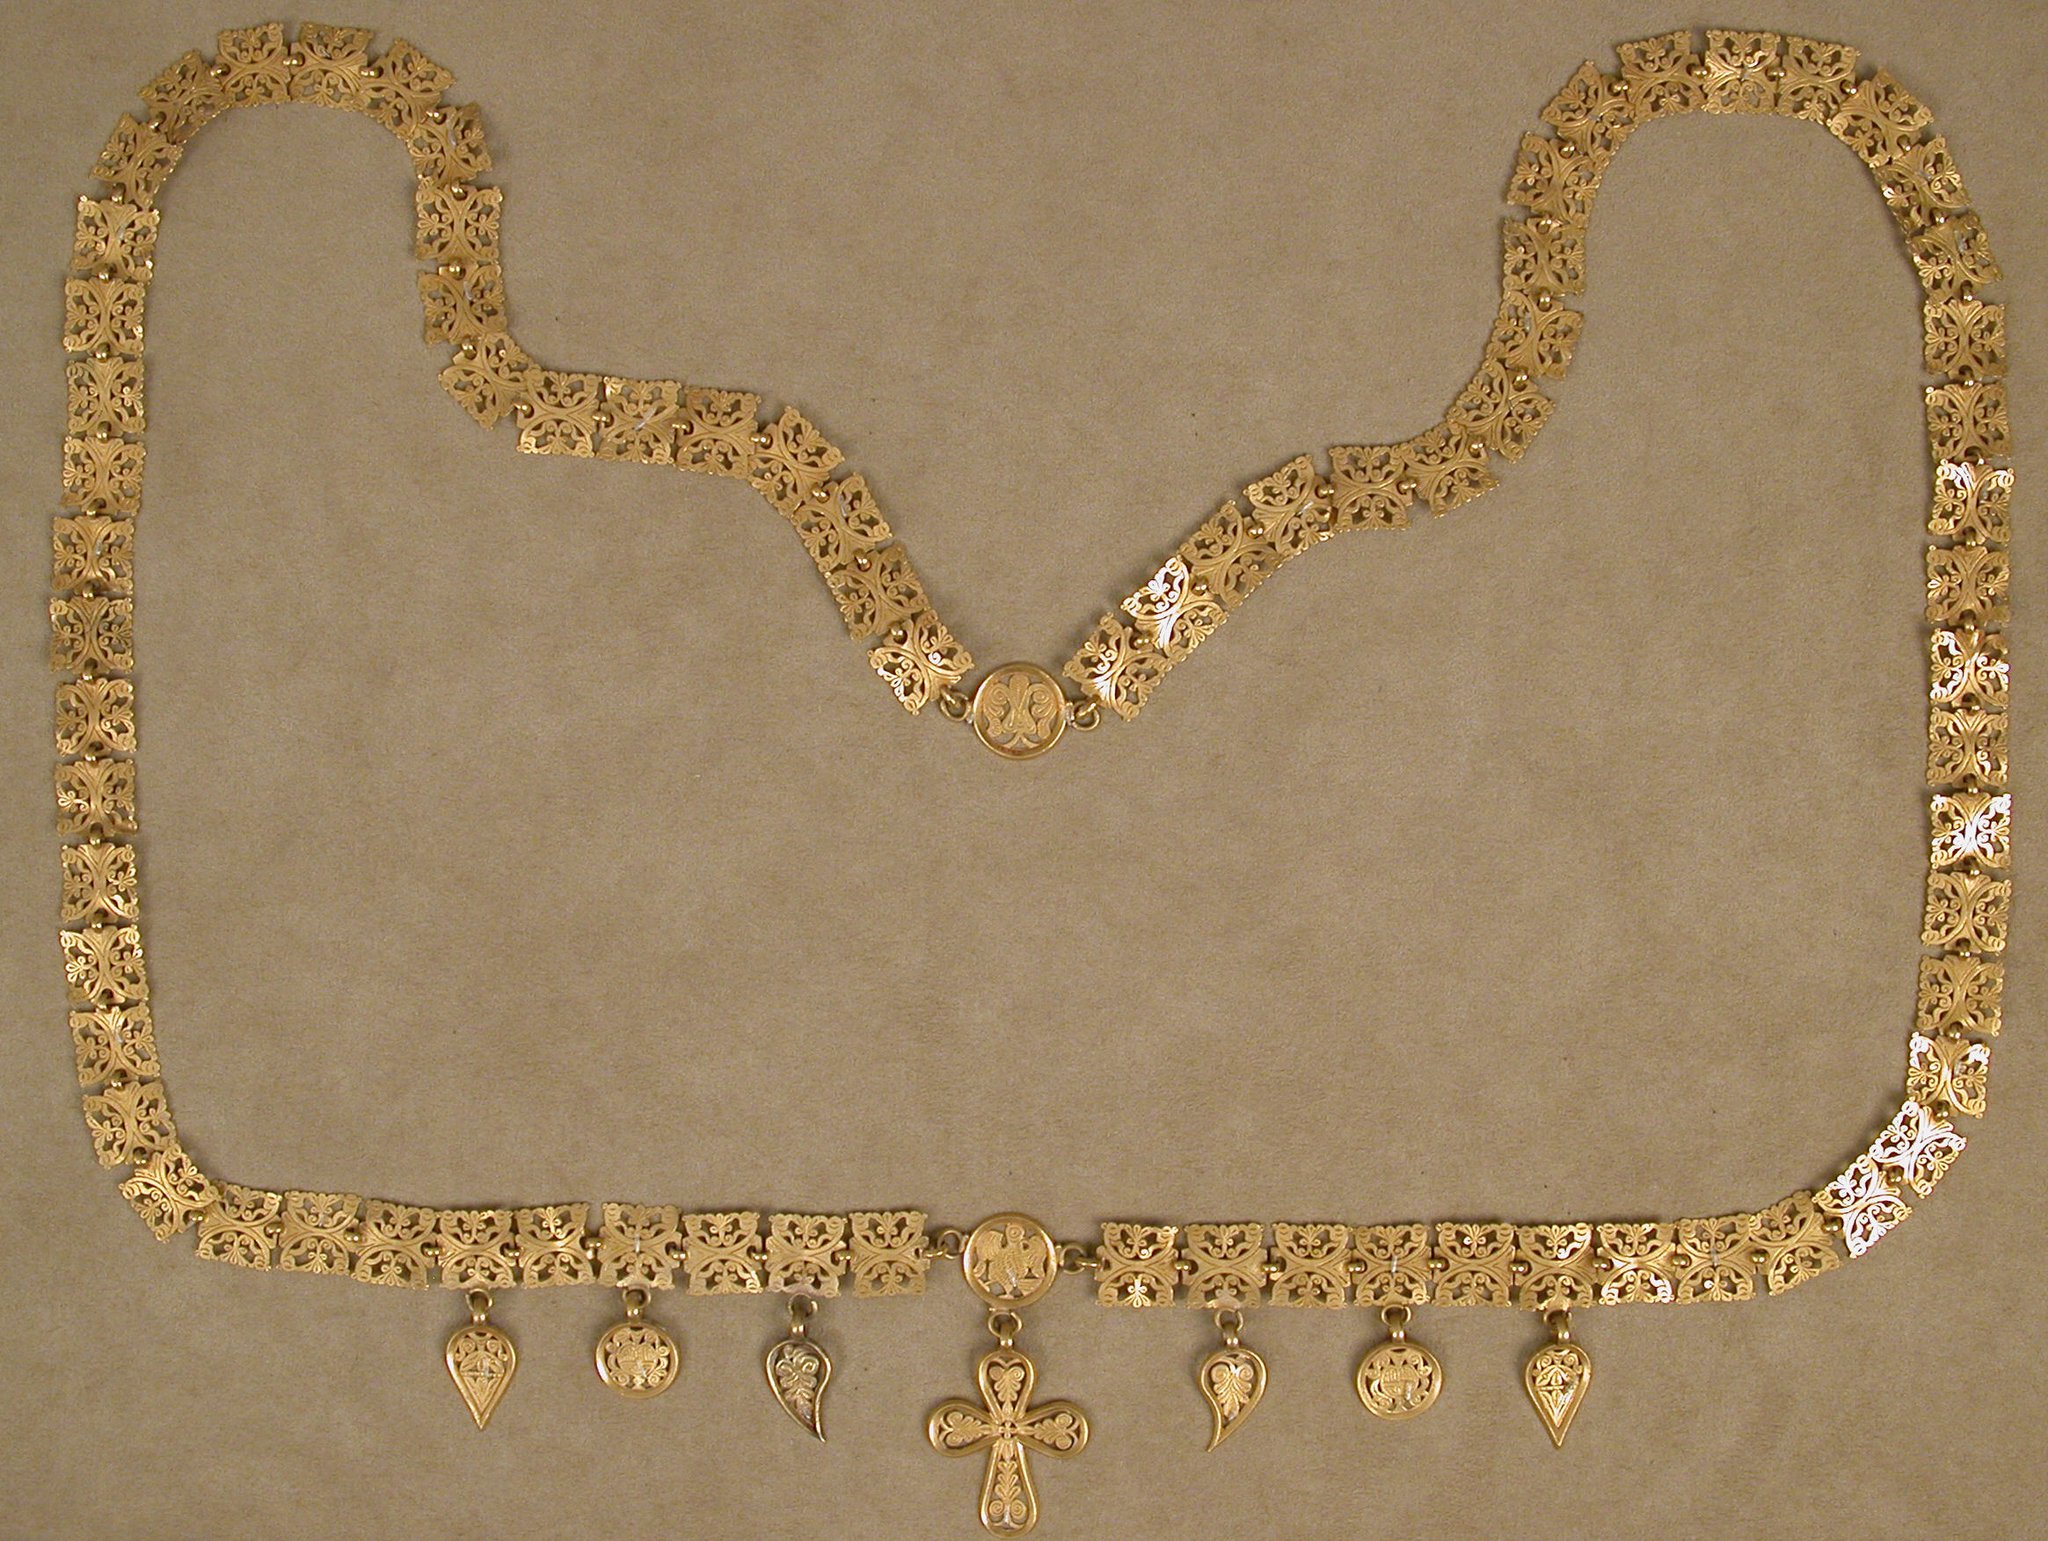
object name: necklace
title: Gold Necklace with Cross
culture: byzantine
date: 501-600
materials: gold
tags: cross